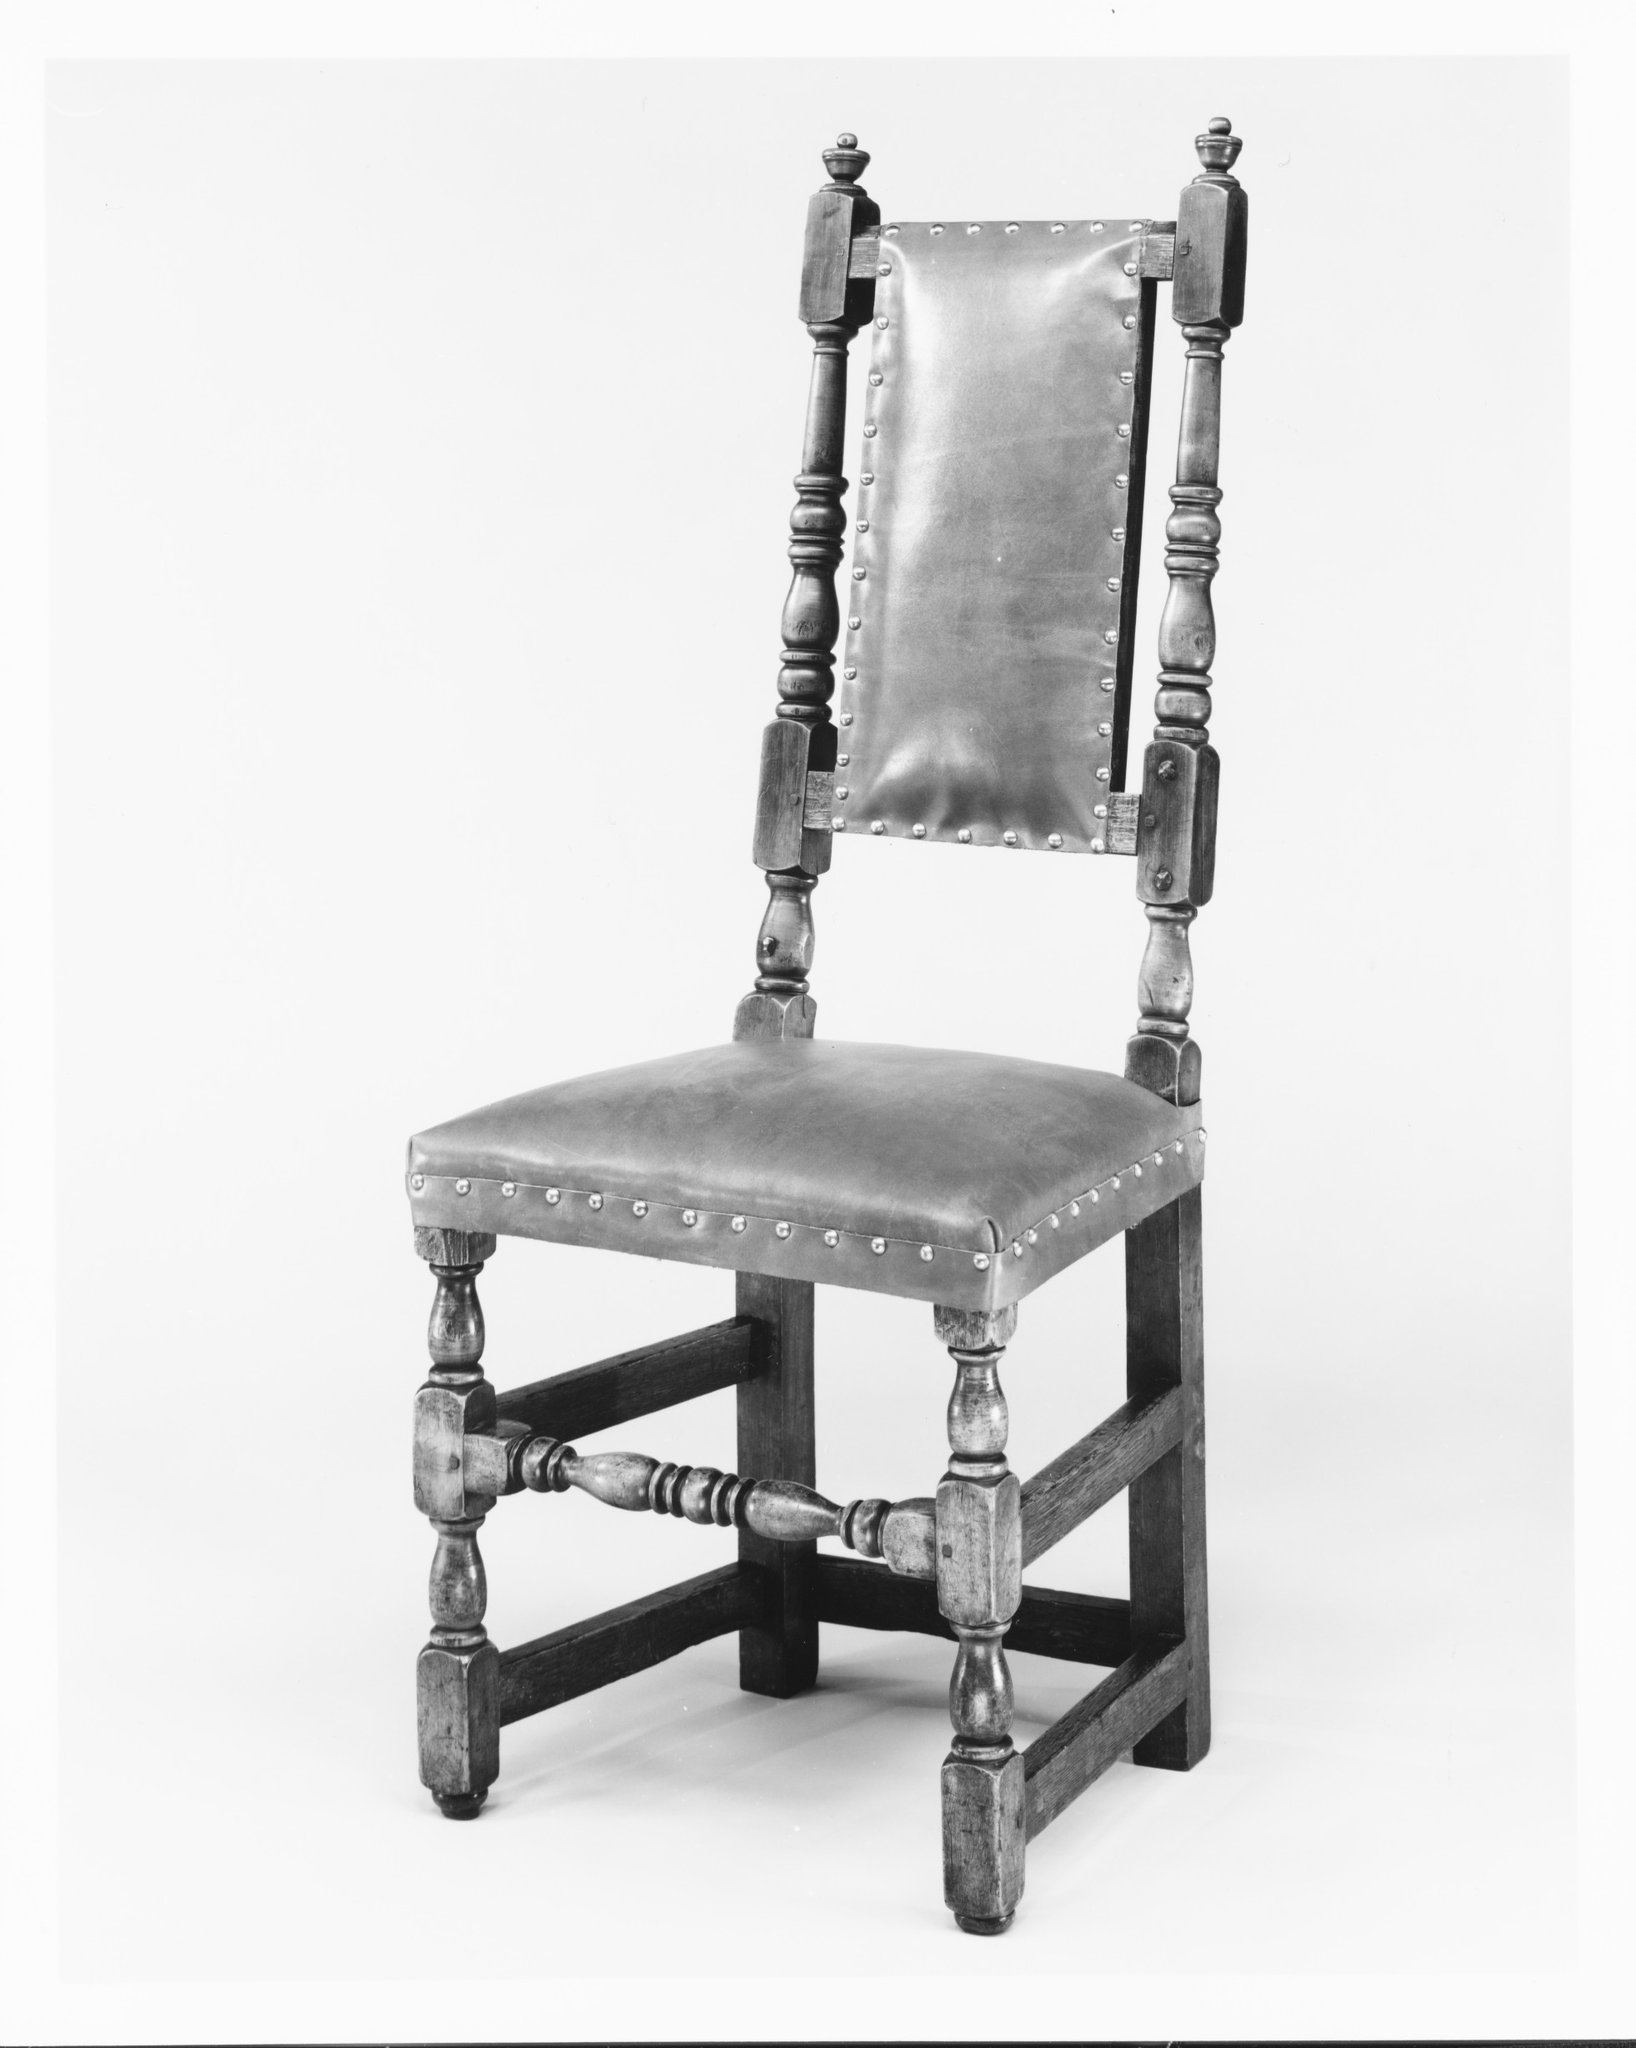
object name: side chair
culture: american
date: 1700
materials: wood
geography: united states